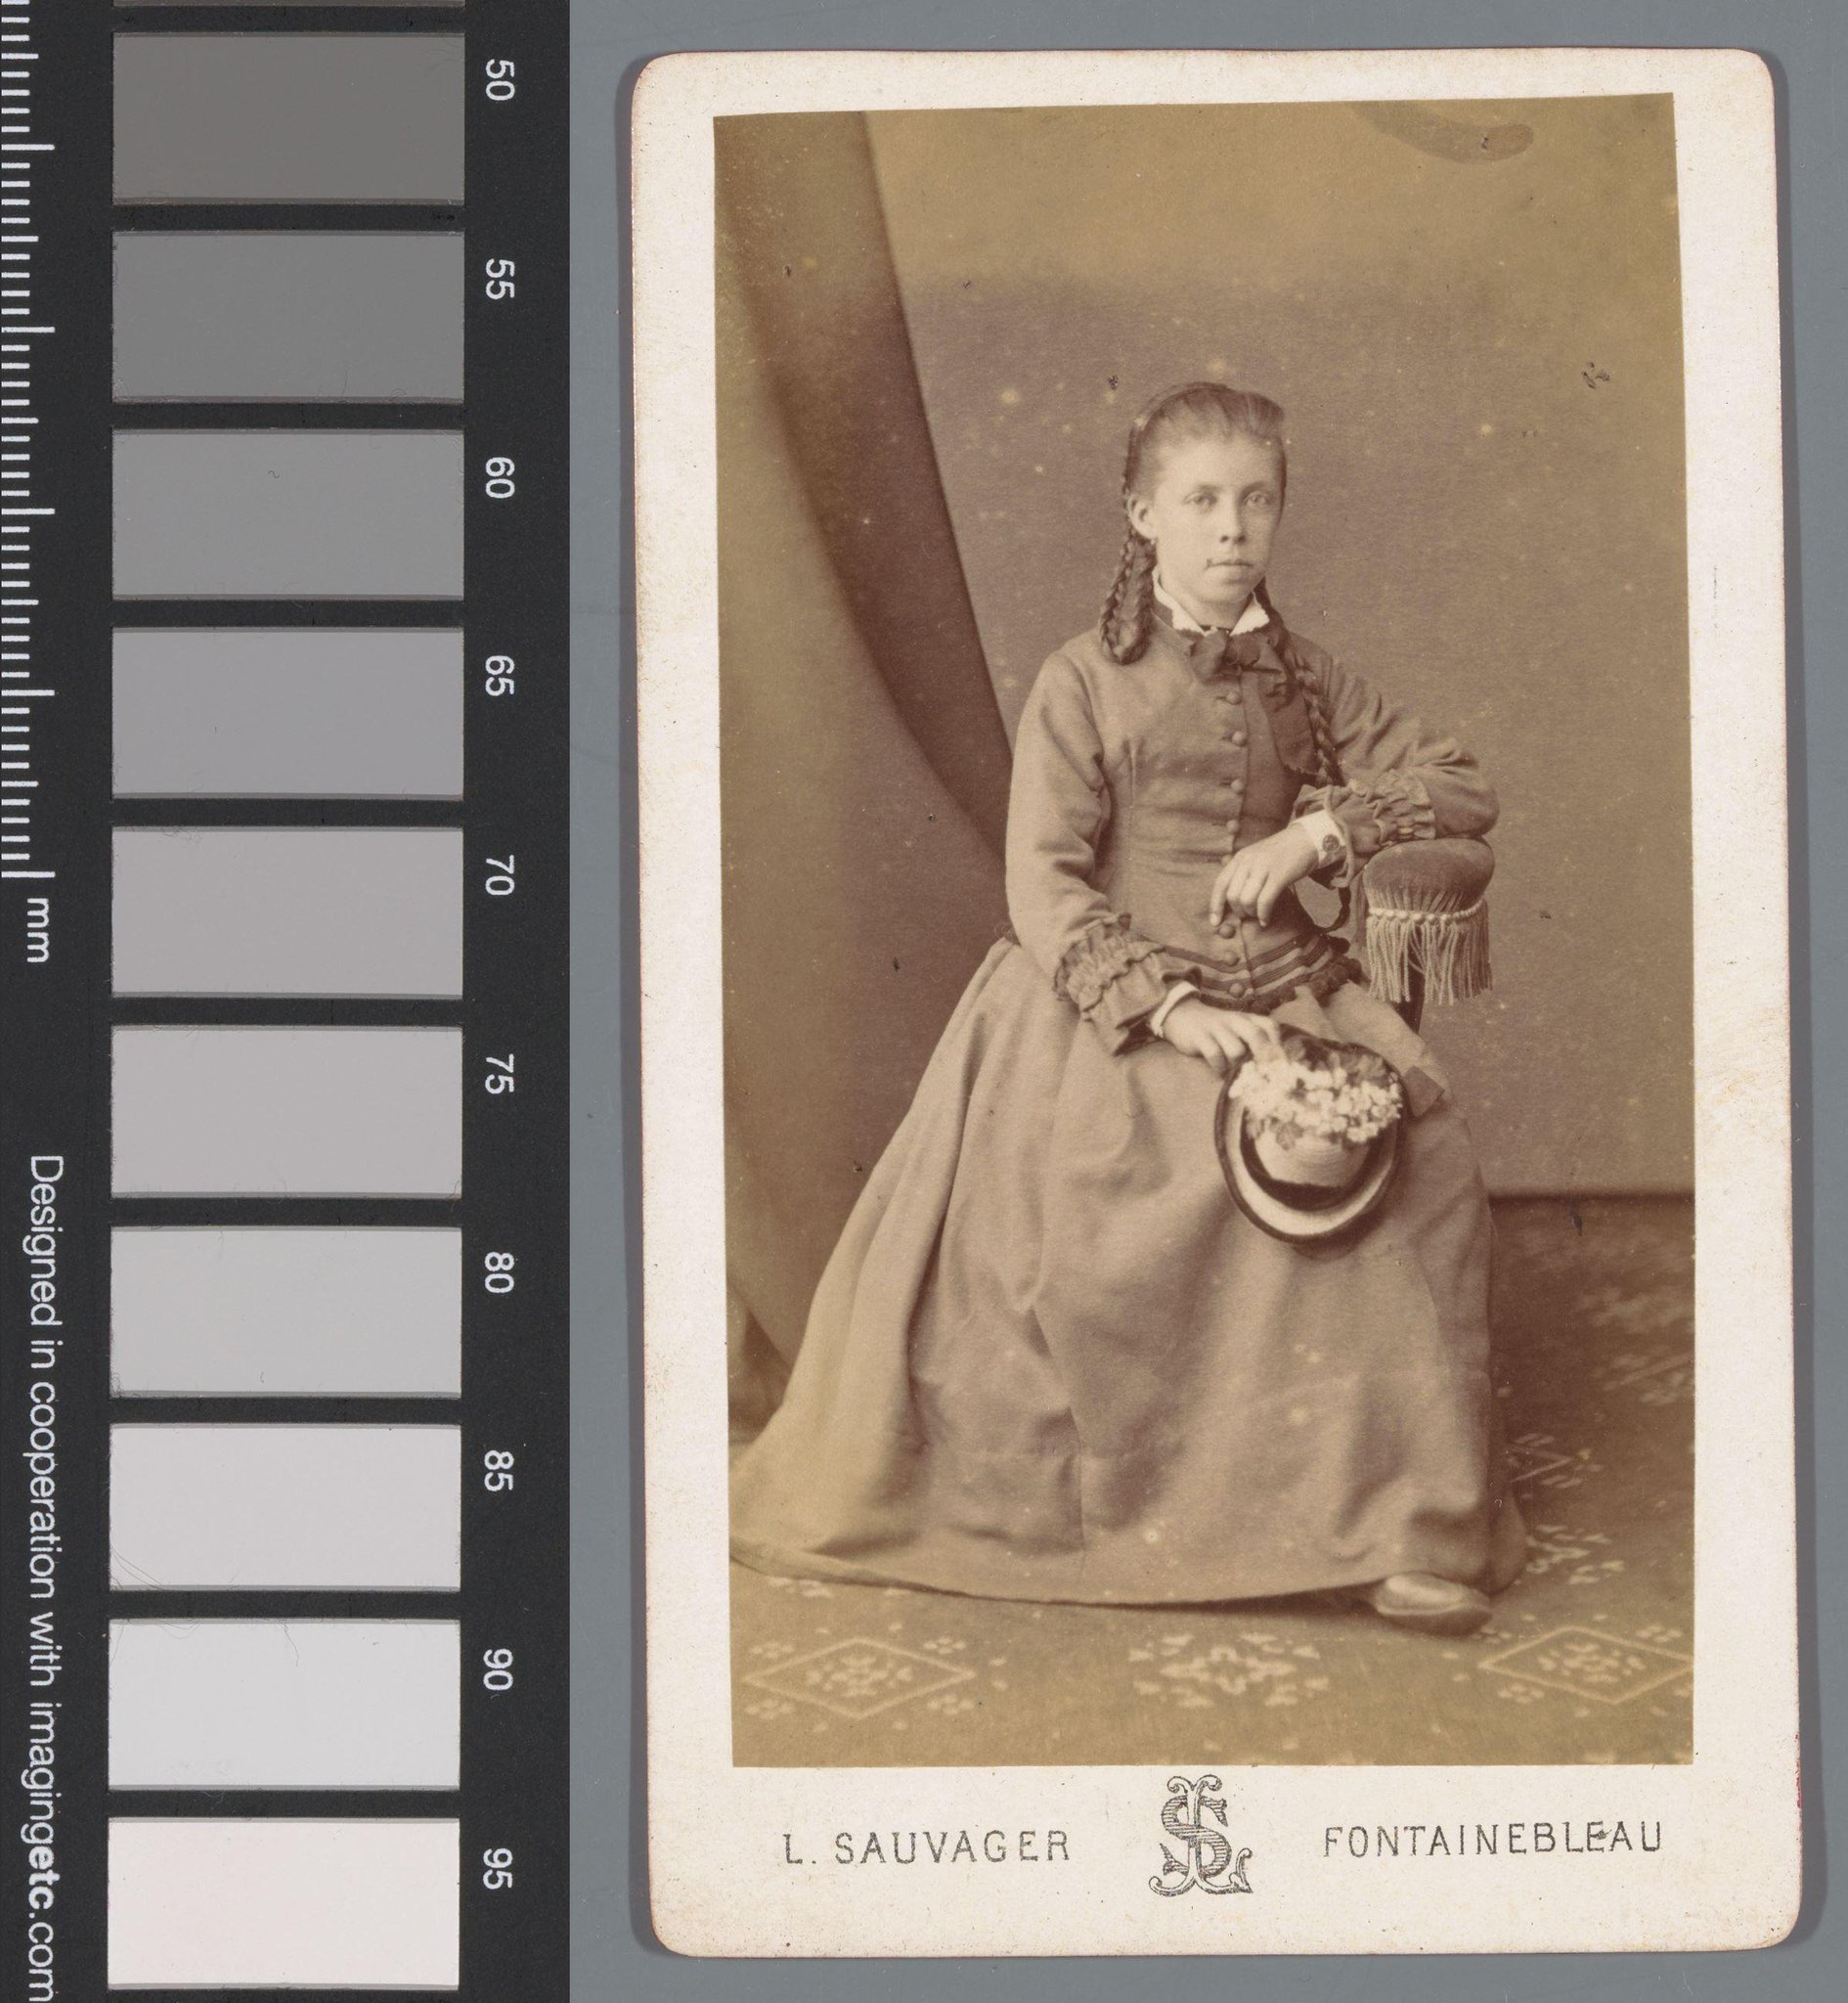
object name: carte de visite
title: Portret van een onbekende jonge vrouw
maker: louis sauvager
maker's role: fotograaf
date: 1855-1885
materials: cardboard, paper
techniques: albumen print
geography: fontainebleau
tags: adolescent, young woman, maiden, anonymous historical person portrayed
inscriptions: monogram: ‘LS’, inscription: ‘L. Sauvager Fontainebleau’, inscription: ‘Photographie hippique/ Fontainebleau/ Grande Rue, 201/ photographie/ L. Sauvager/ Nota: Tous les Clichés sont conservés./ Vues du palais et de la forêt.’